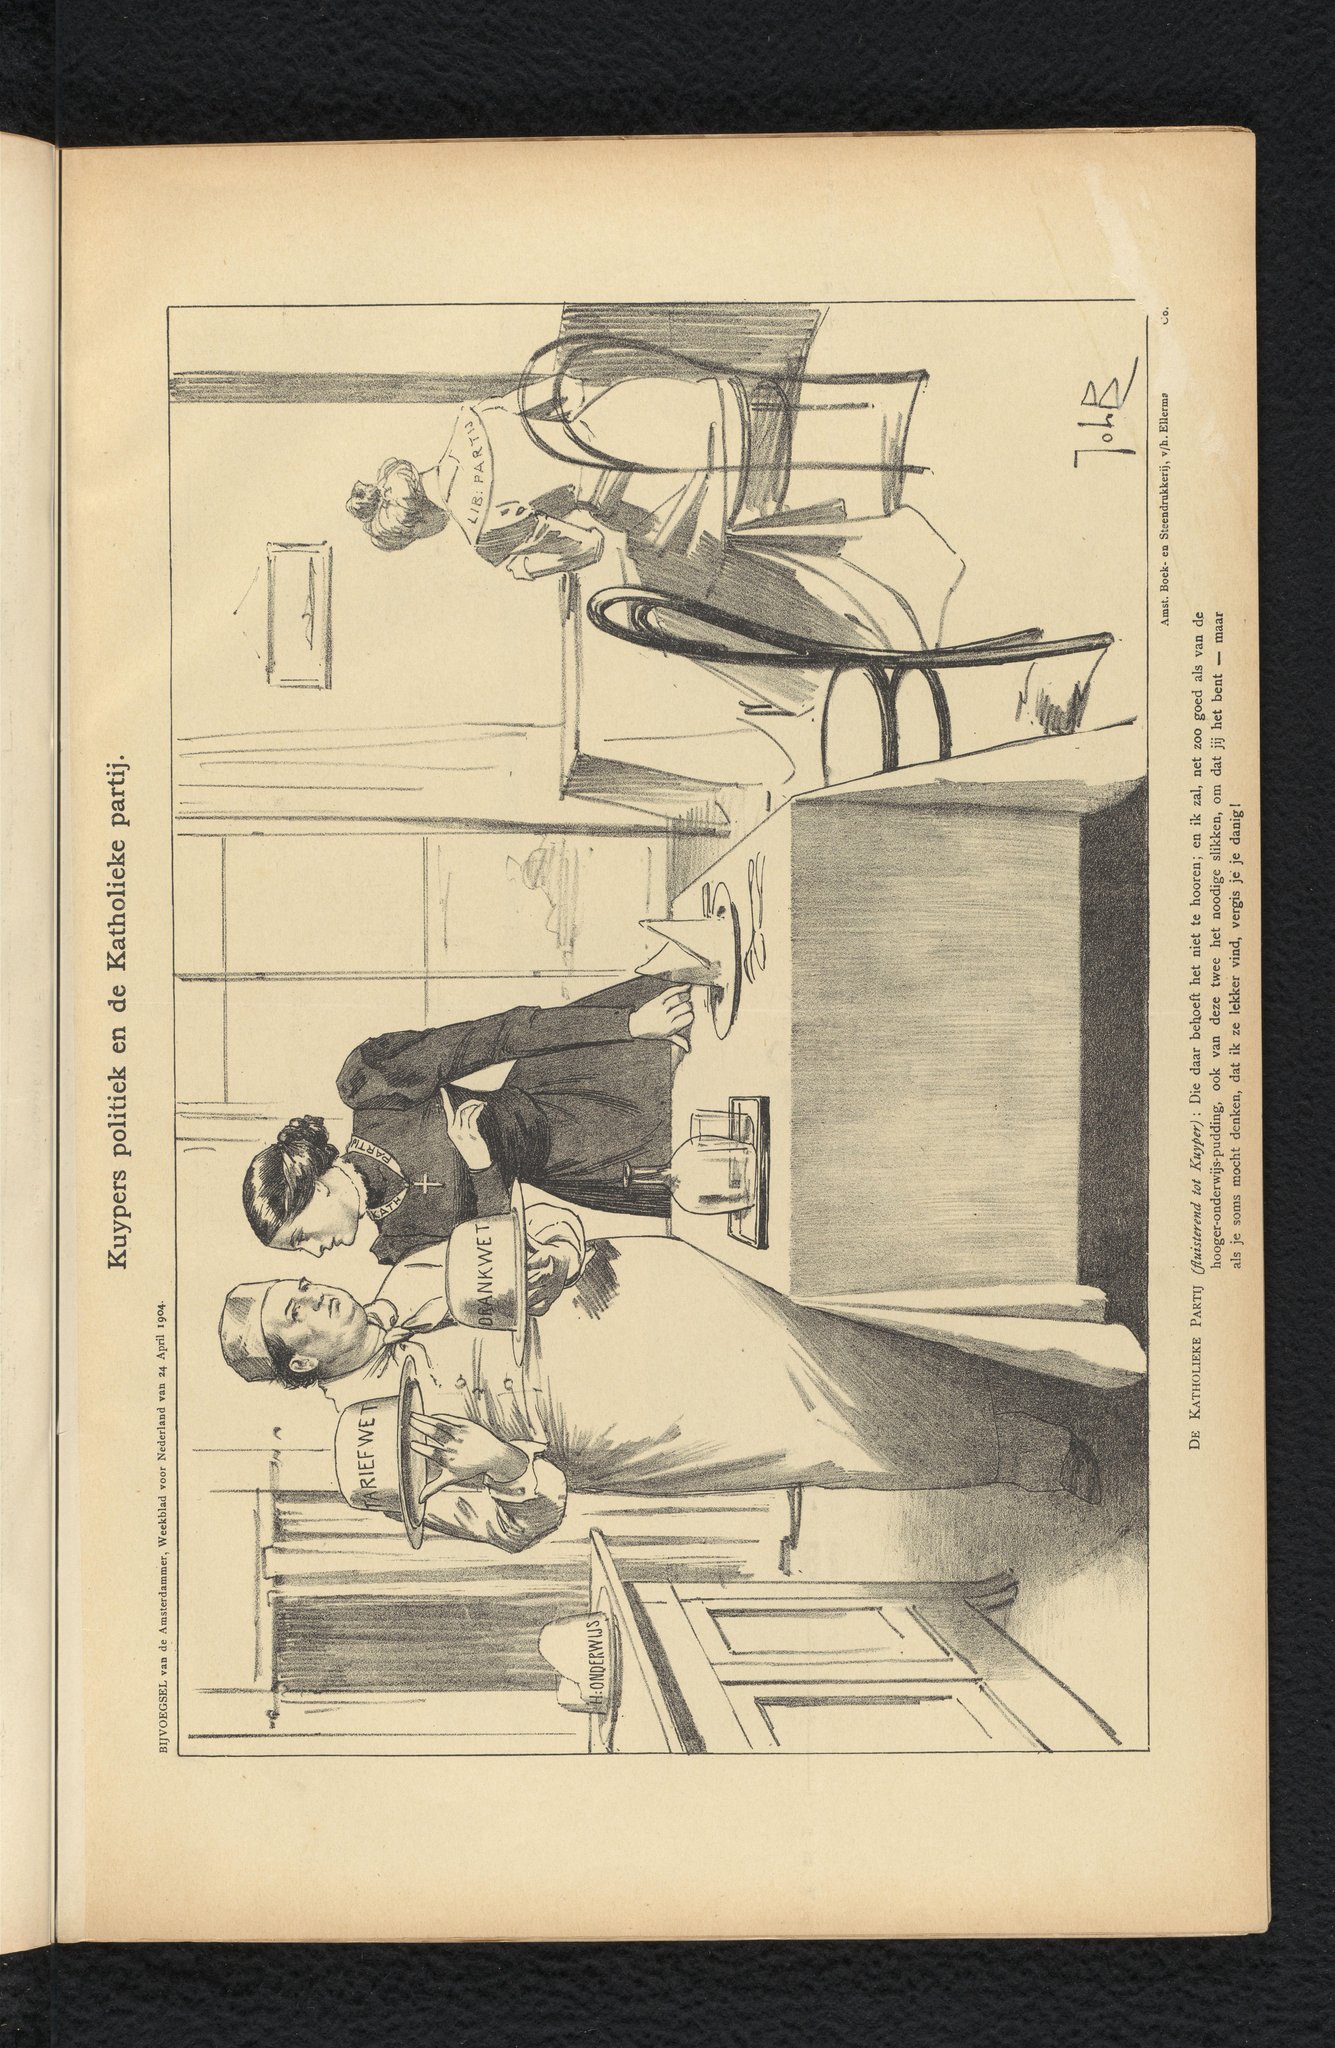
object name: cartoon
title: Kuypers politiek en de Katholieke partij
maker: johan braakensiek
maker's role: draughtsman, print maker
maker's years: 1858-1940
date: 1904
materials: paper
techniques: lithograph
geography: amsterdam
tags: the hague, abraham kuyper, cook, baker, bread, cake, pastry, etc., political parties, political caricatures and satires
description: Premier Kuyper als bakker met twee puddingen (wetten) bij de Katholieke partij, de vrouw des huizes. Zij belooft er van te eten, maar zonder dat de Liberale partij ervan hoort.